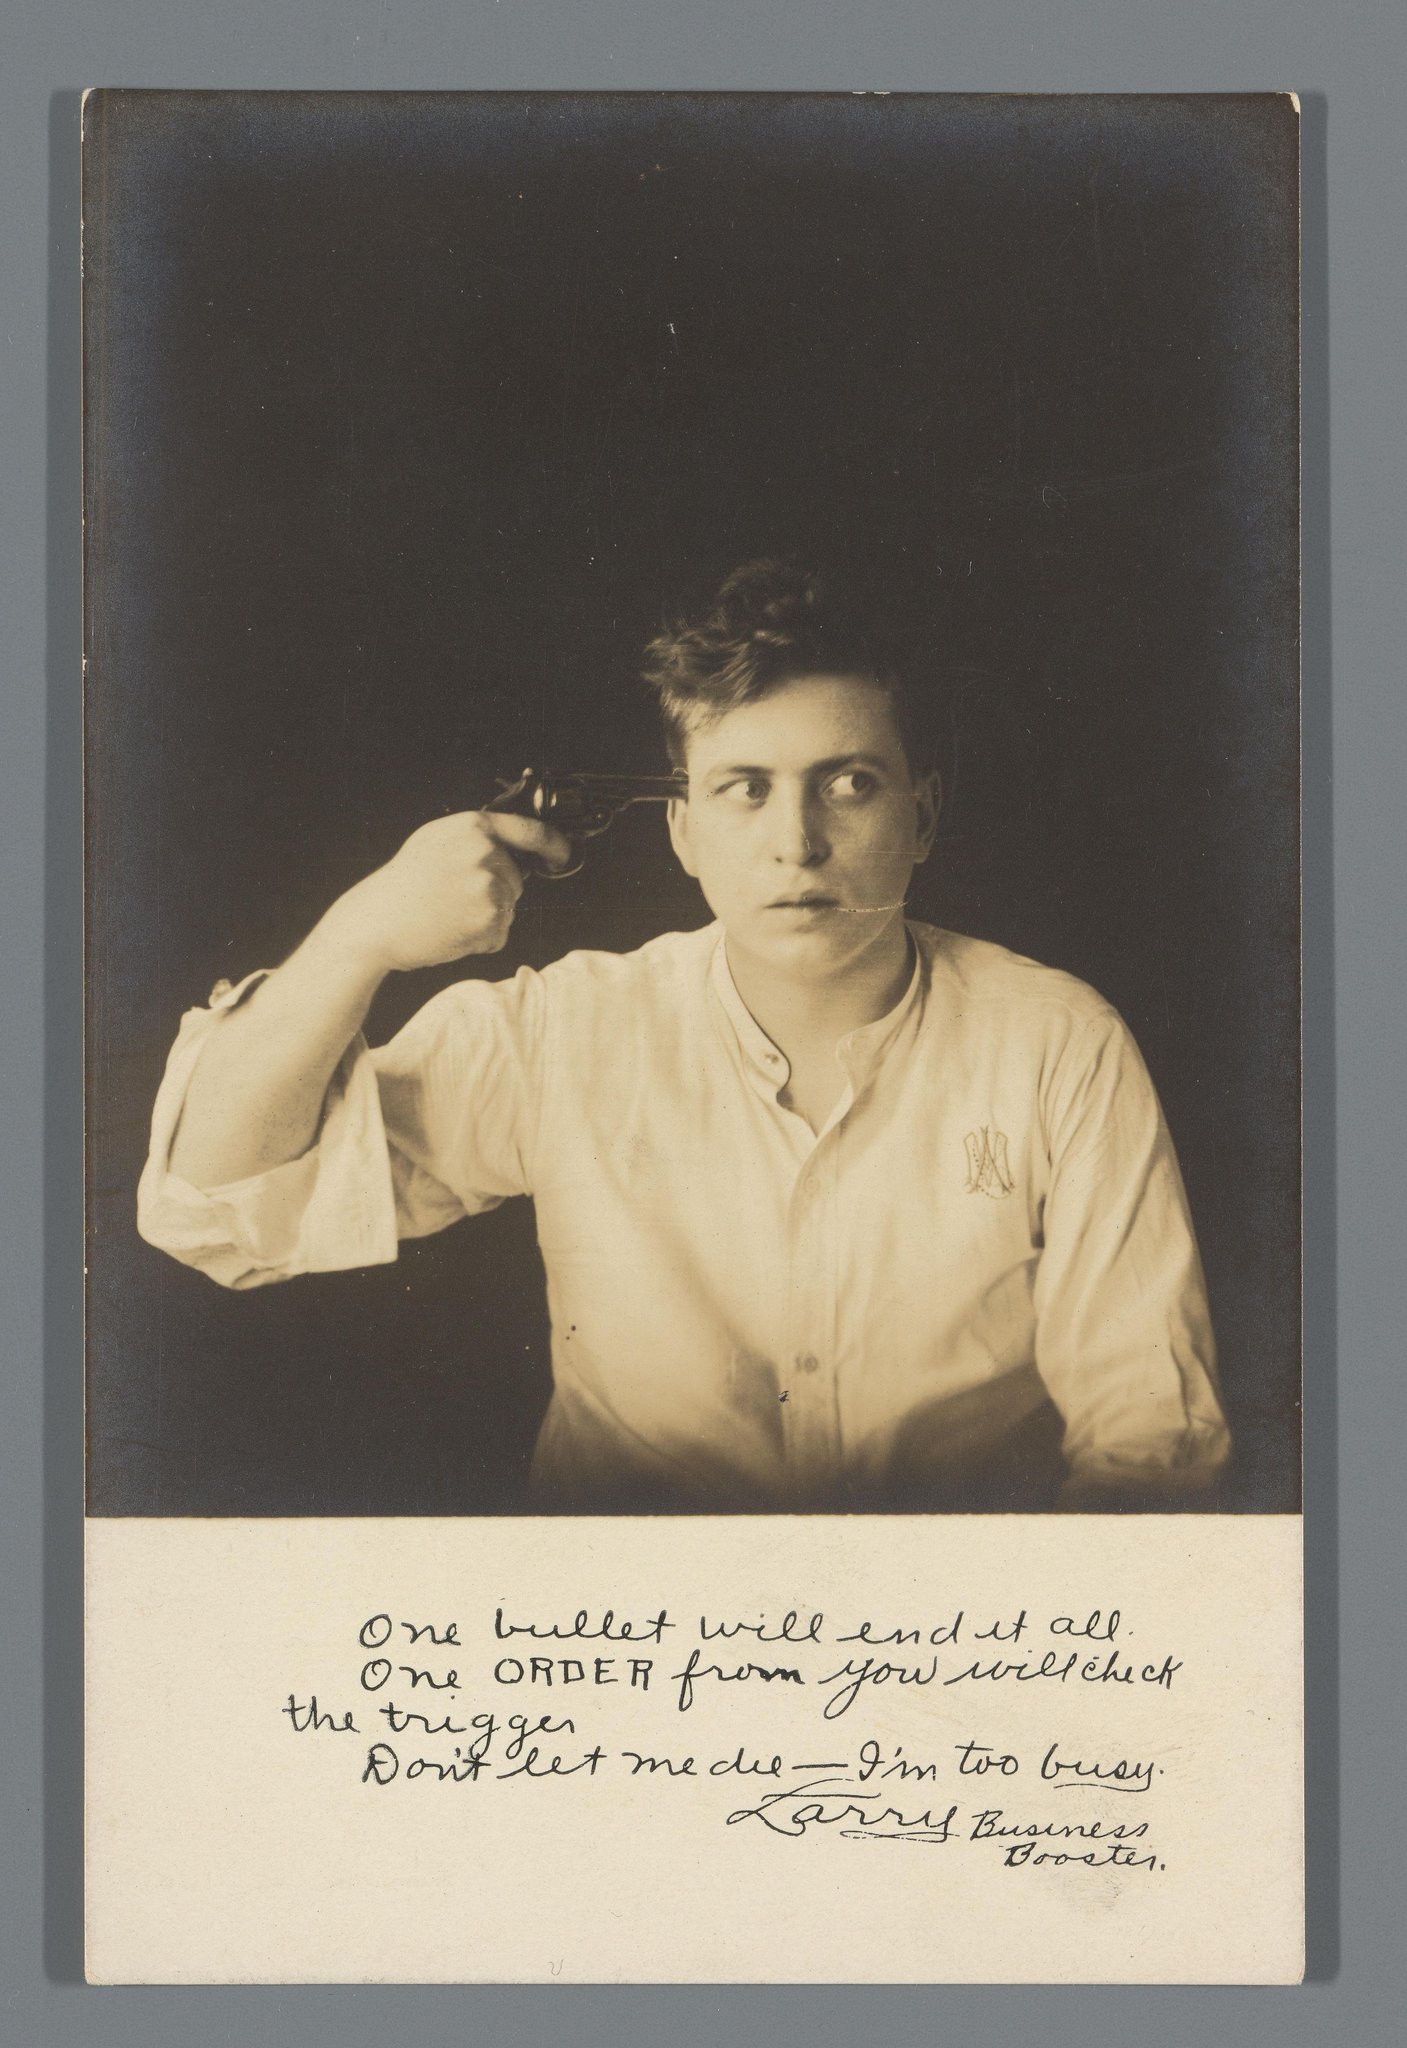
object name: ansichtkaart, prentbriefkaart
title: Reclame voor Kahn Bros, Louisville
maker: Anonymous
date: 1930-1950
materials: photographic support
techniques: gelatin silver print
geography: united states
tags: bedrijf, kahn bros, louisville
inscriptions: inscription, inscription